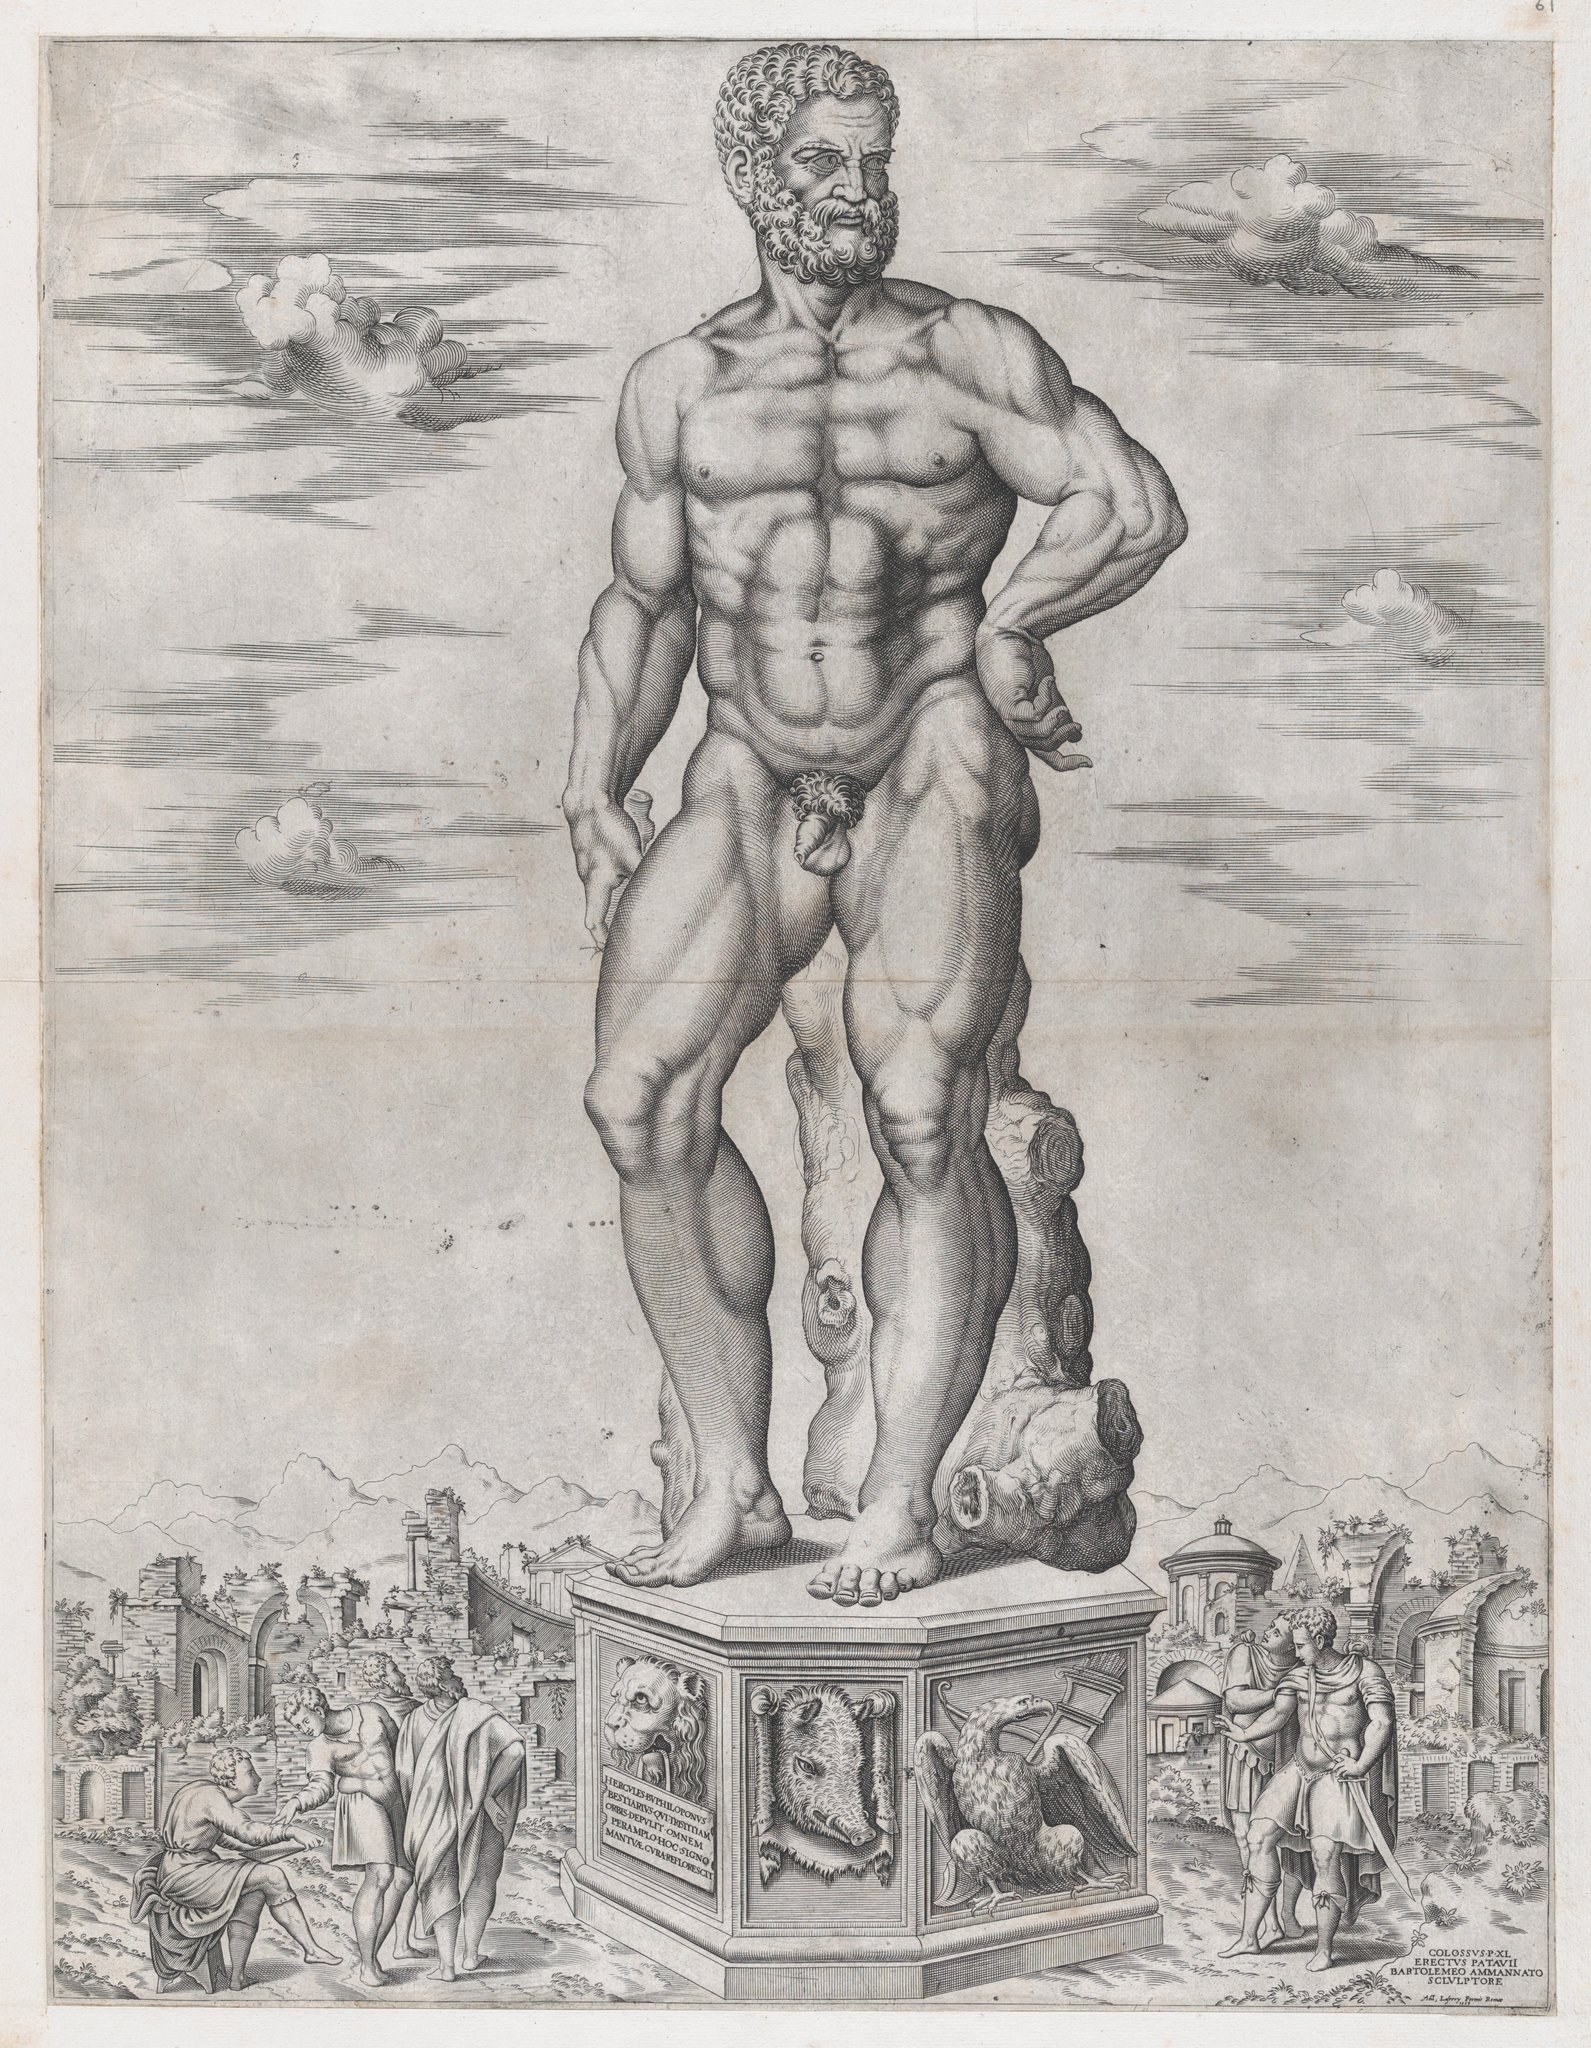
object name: print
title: Hercules Colossus at Padua (L'Ercole di casa Benavides a Padova), from "Speculum Romanae Magnificentiae"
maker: anonymous, italian, 16th century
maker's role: artist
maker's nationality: italian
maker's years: 1500-1600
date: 1553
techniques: engraving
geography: rome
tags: eagles,men,hercules,lions,pigs